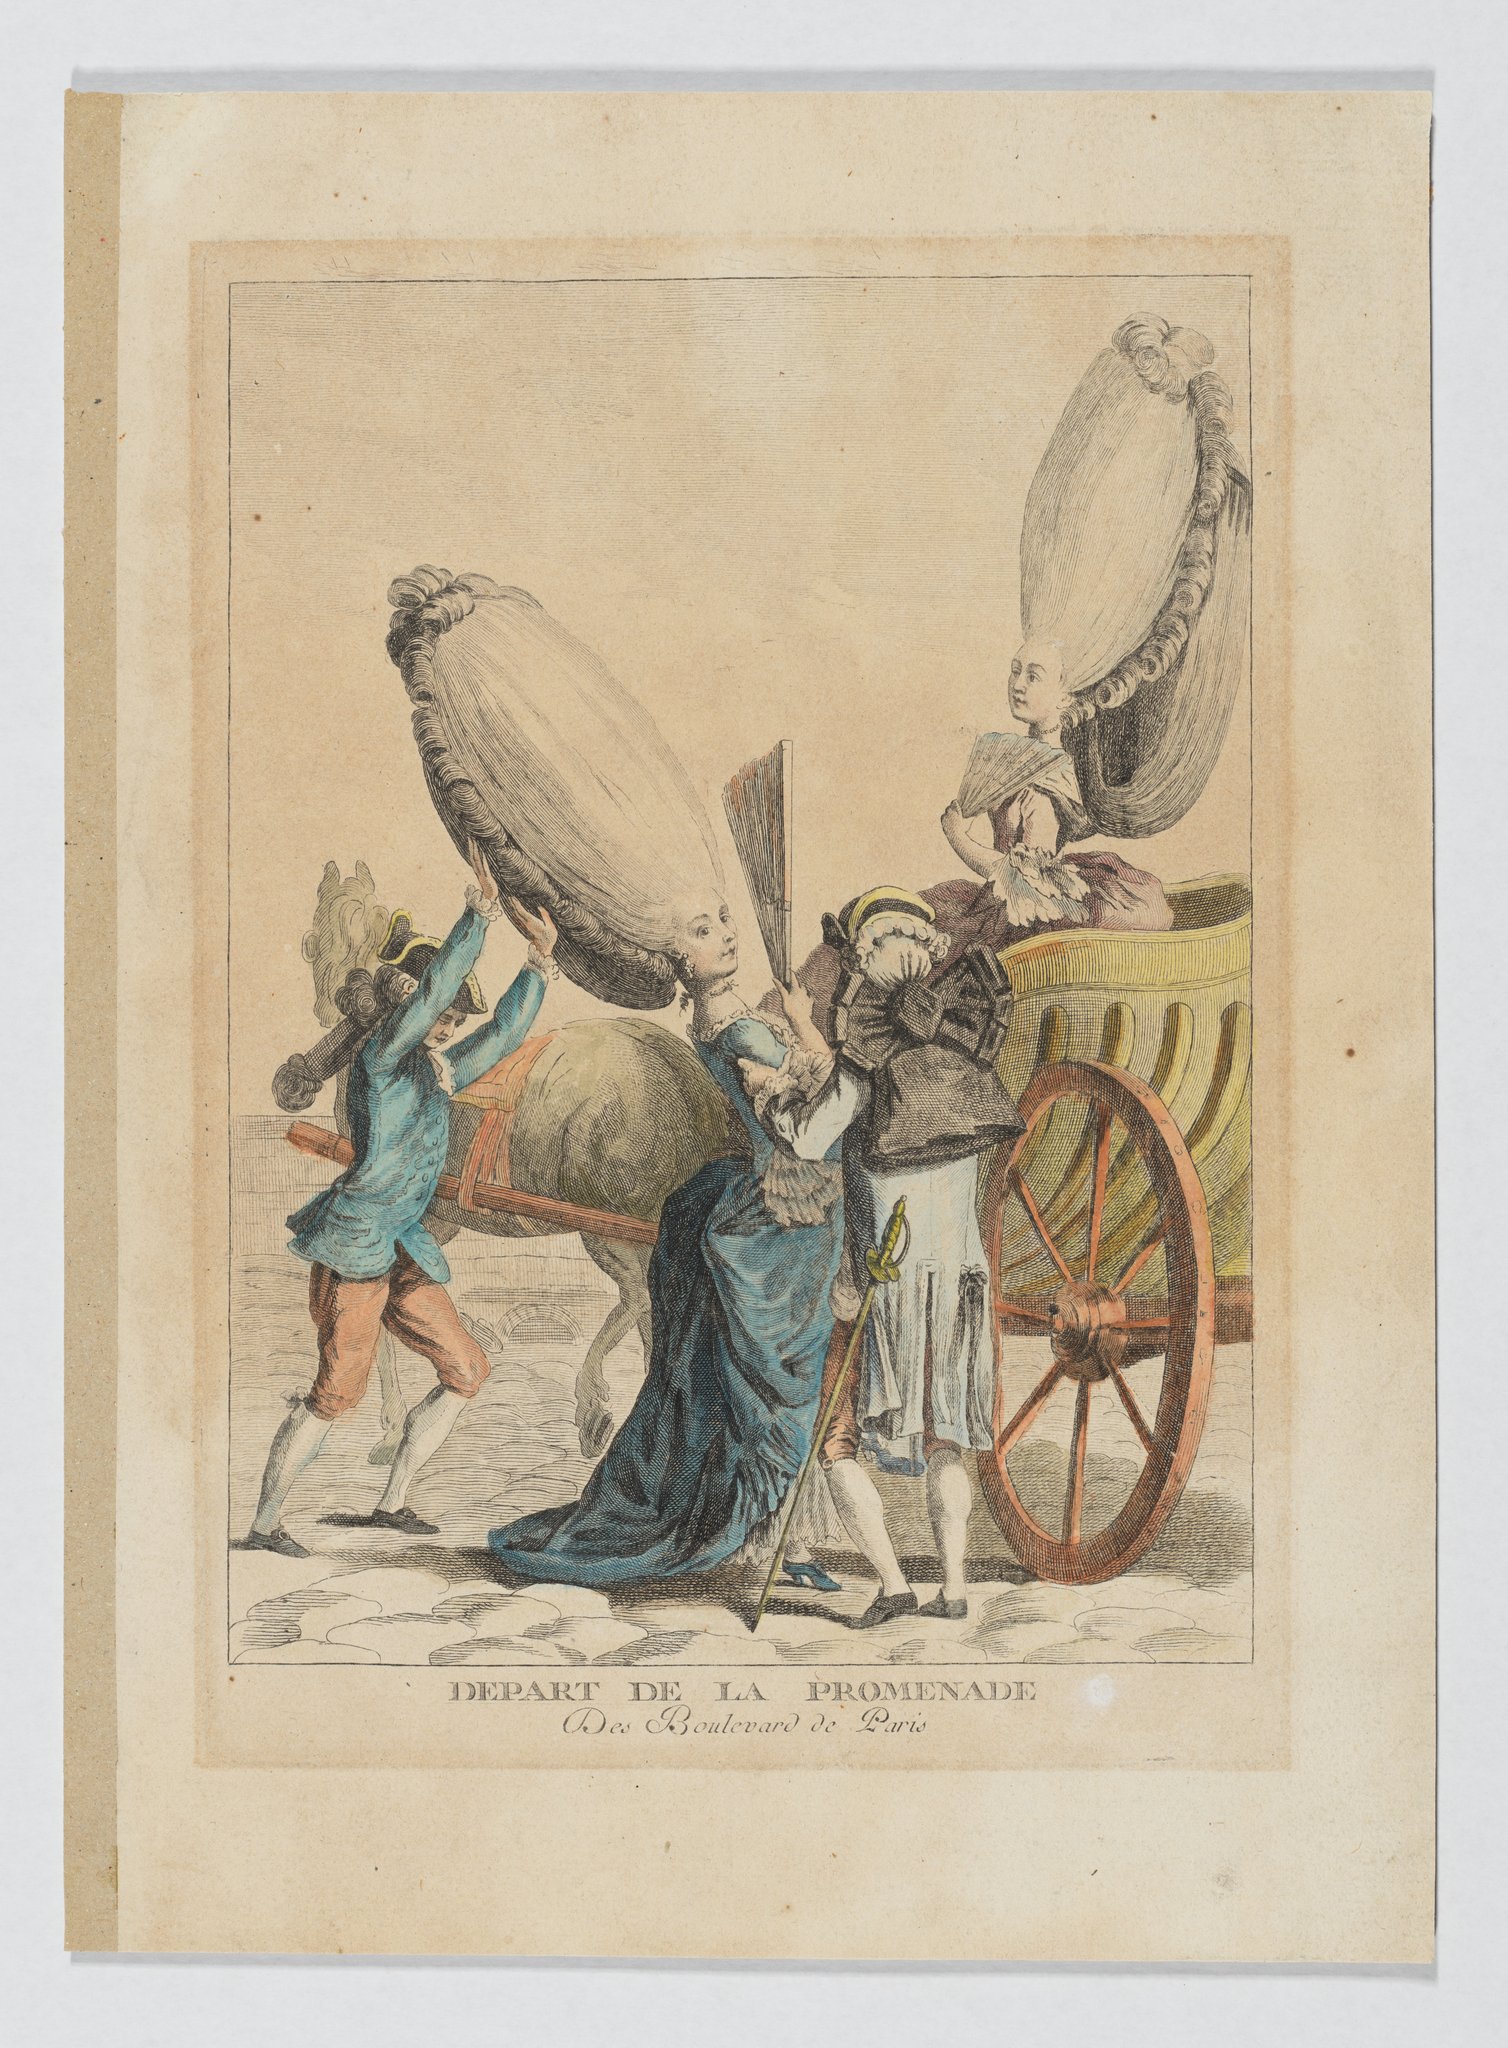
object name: print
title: Depart de la Promenade, Des Boulevard de Paris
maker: anonymous, french, 18th century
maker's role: artist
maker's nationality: french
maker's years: 1700-1800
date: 1770-1780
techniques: etching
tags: hair,men,women,carriages,caricature,wigs